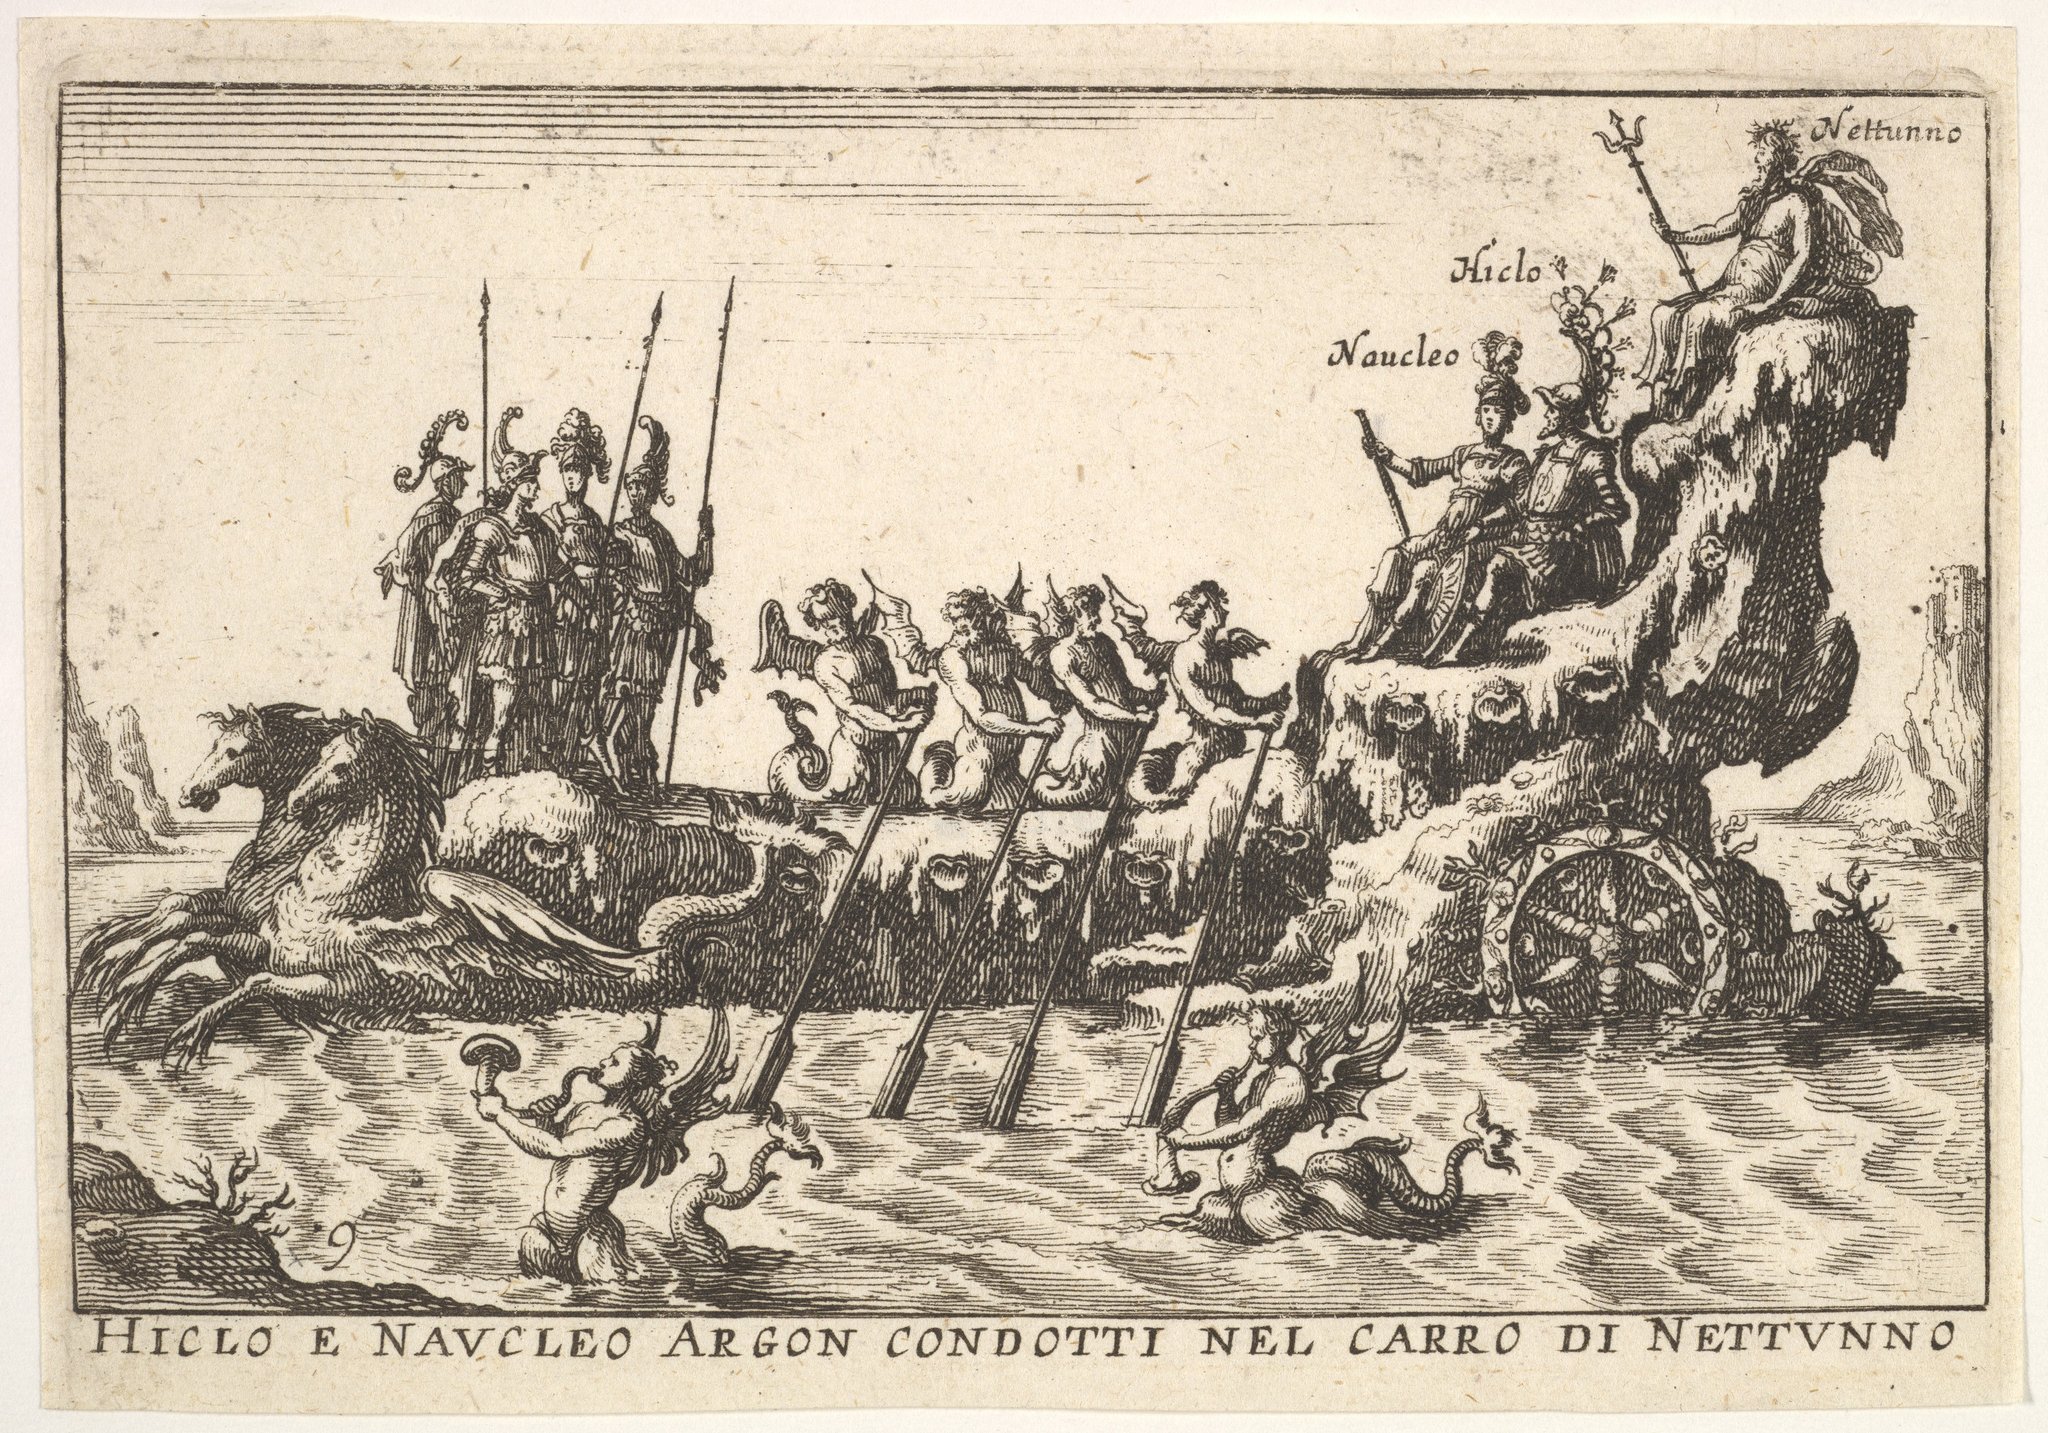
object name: print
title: Plate 9: Argonauts Hicleus and Naucleus led in the float of Neptune (Hicleo e Naucleo Argon. condotti nel carro di Nattunno), from "The magnificent pageant on the river Arno in Florence for the marriage of the Grand Duke" (Le Magnifique carousel fait sur le fleuve de l'Arne a Florence, pour le mariage du Grand Duc)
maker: Anonymous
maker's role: artist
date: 1664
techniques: etching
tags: argonauts,neptune